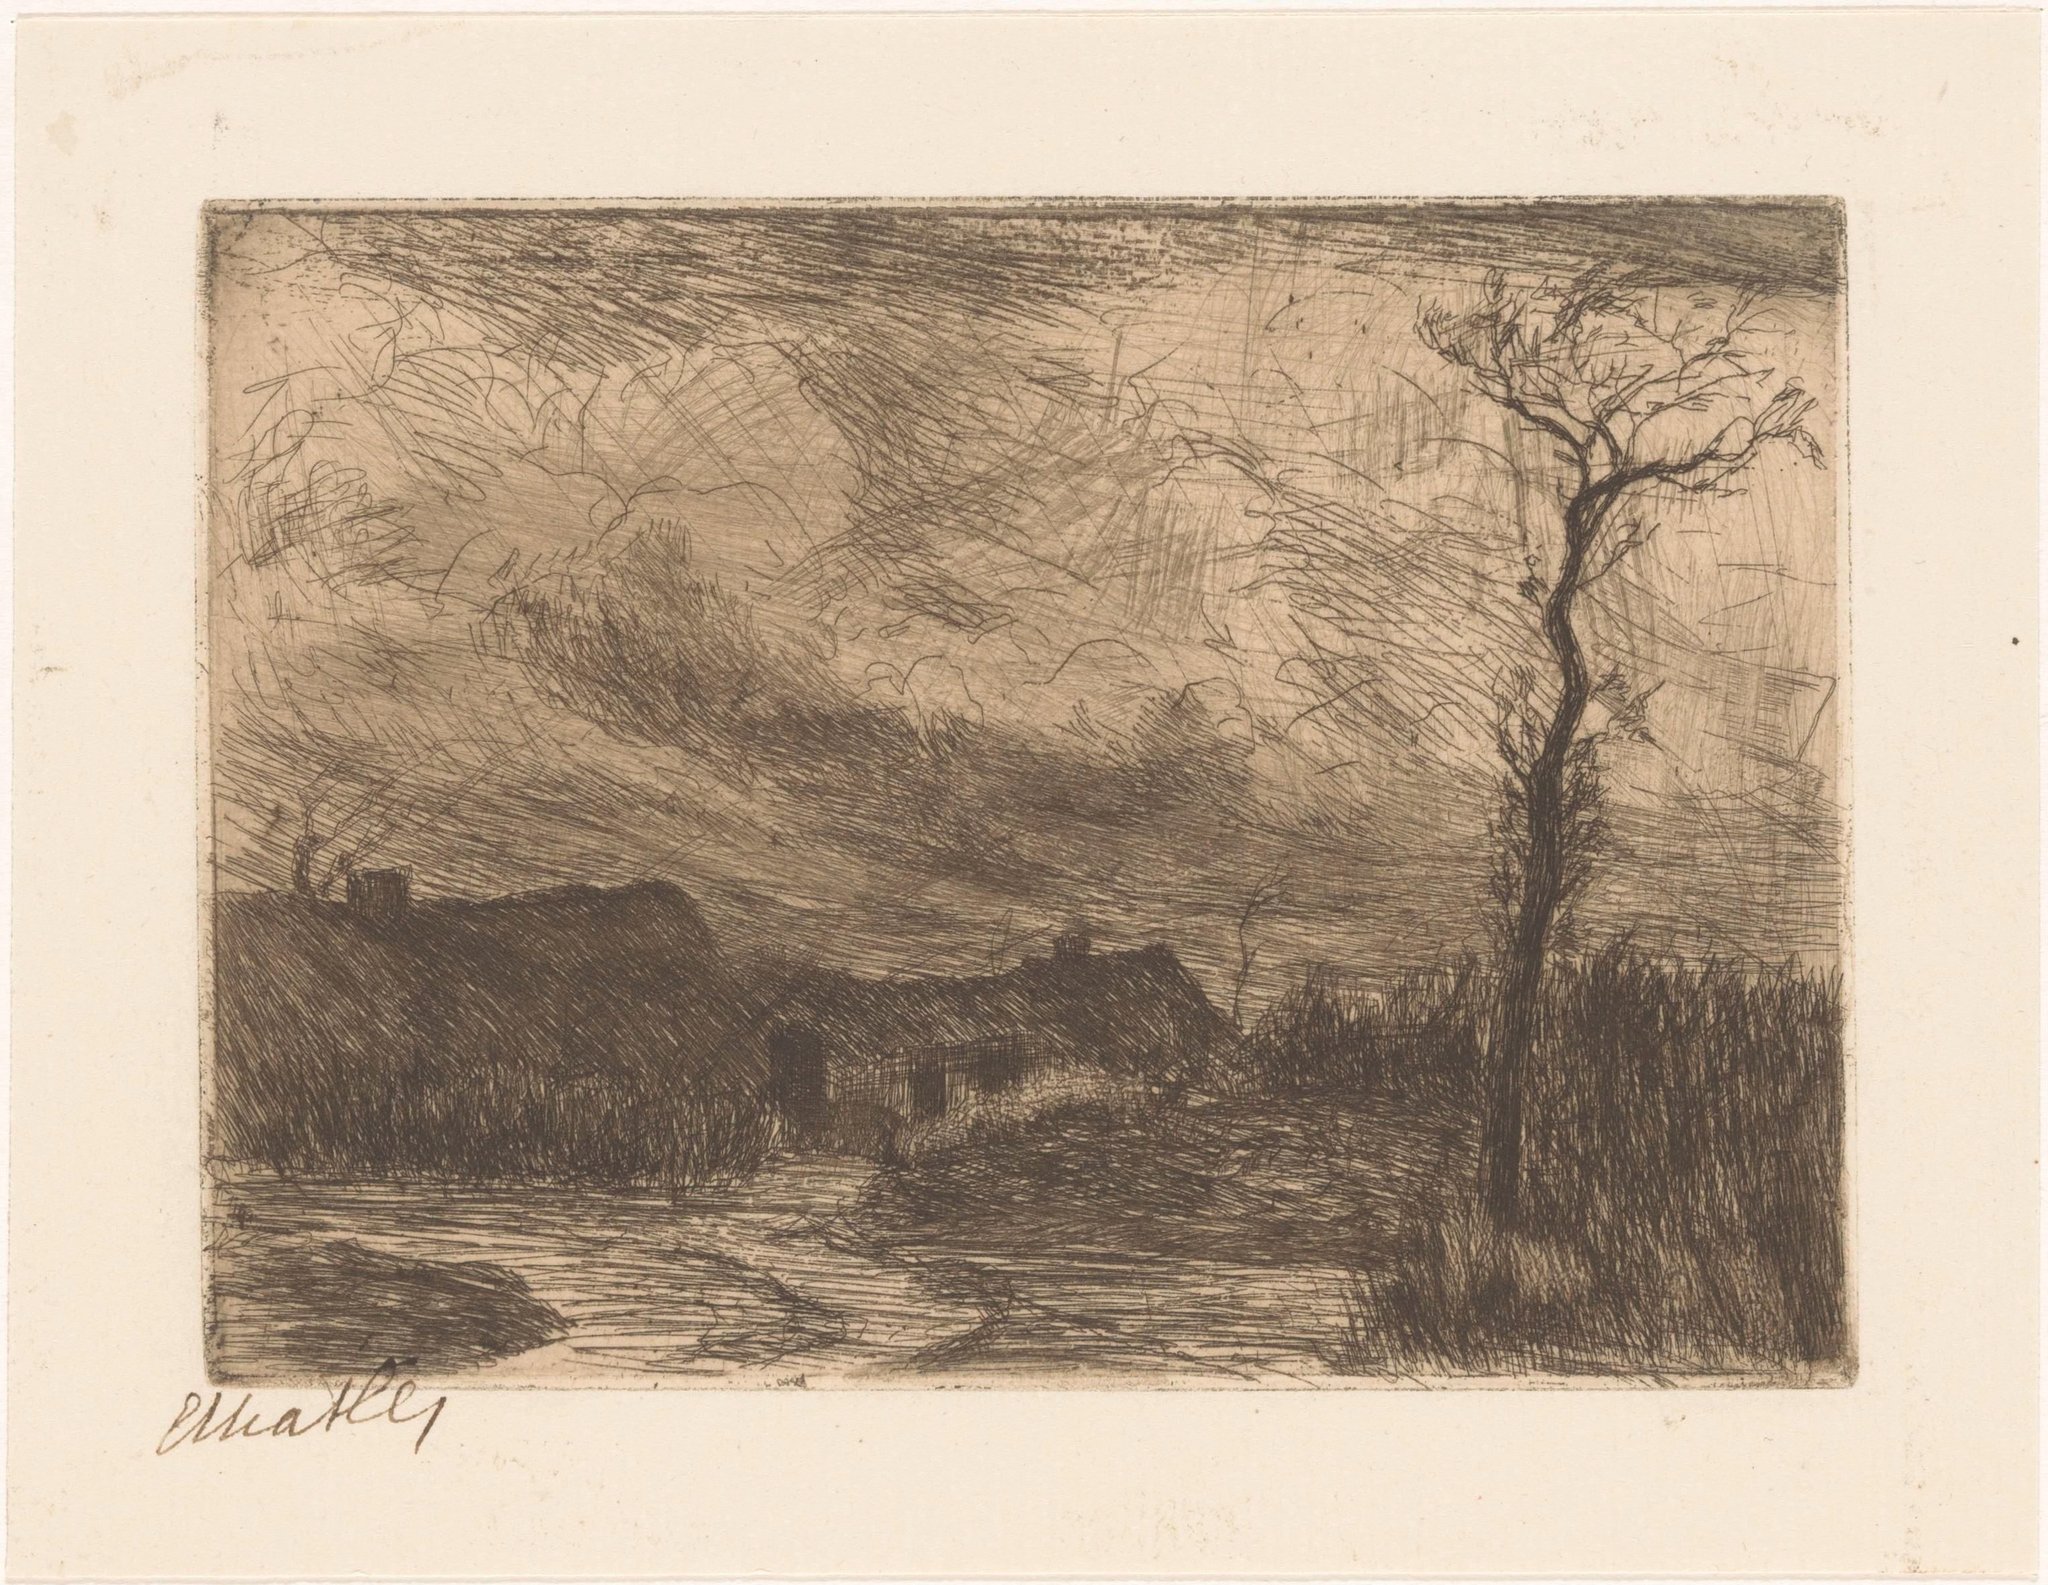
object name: print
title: Huizen onder een zware lucht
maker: etha fles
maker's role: print maker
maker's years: 1857-1948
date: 1867-1910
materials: paper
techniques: drypoint, intaglio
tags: rural housing, e.g. country-house, villa, cottage, low clouds and those originating from rising air currents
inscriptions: collector's mark: Lugt 2228